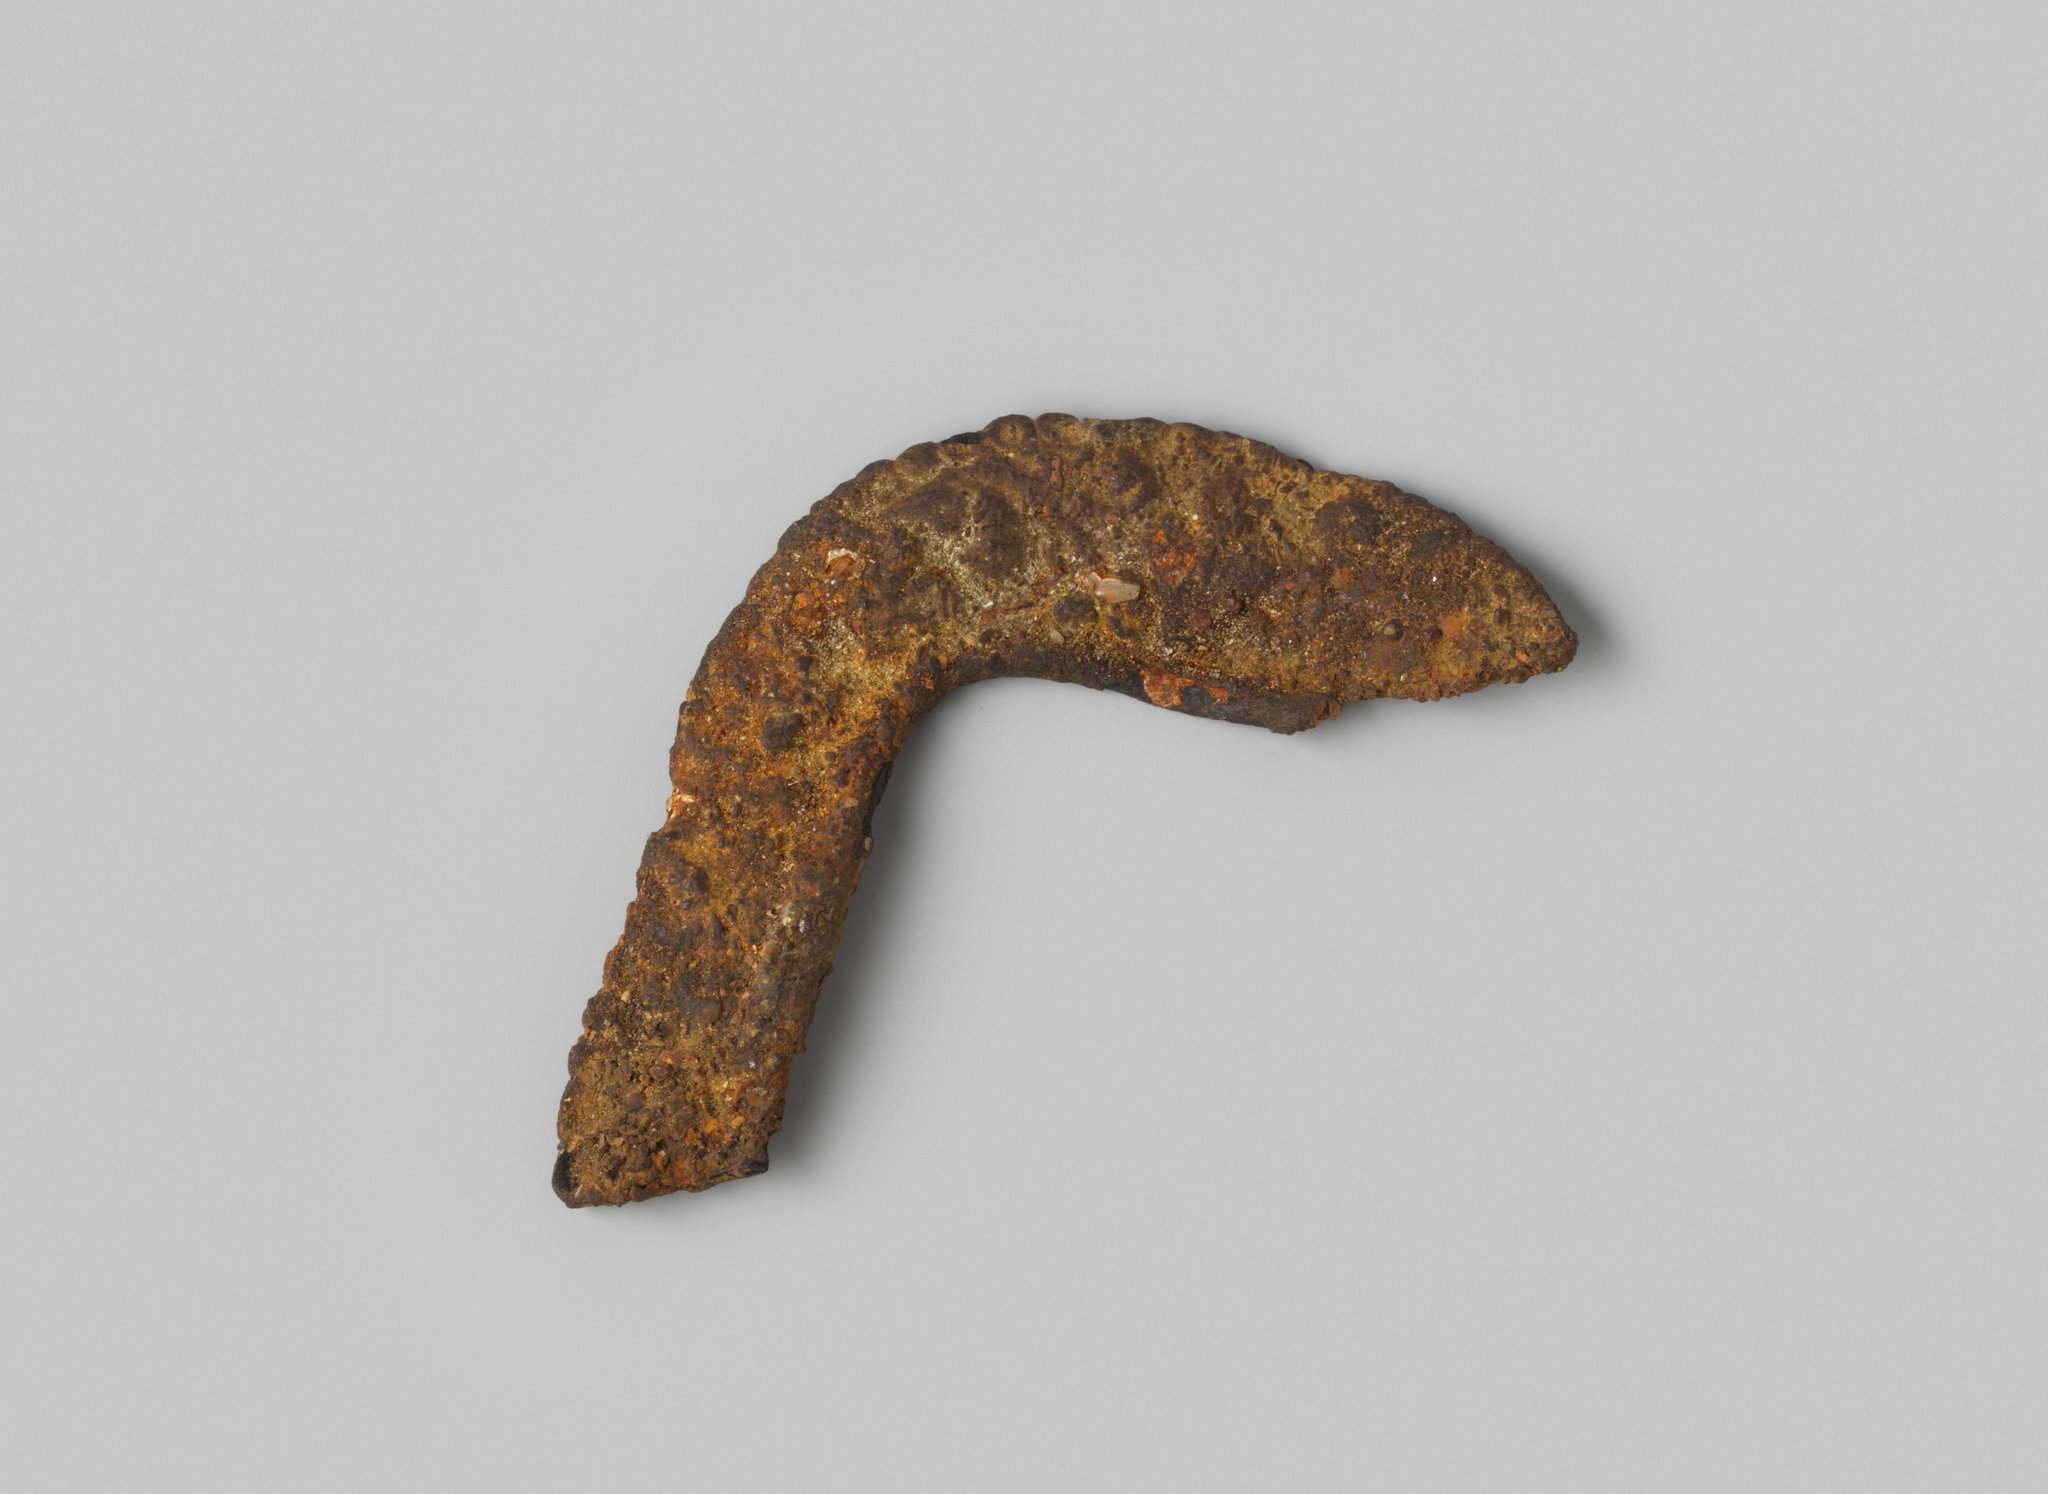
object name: shoe buckle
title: Fragment schoengesp uit het wrak van de Oost-Indiëvaarder Hollandia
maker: Anonymous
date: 1700-1743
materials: silver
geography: netherlands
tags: verenigde oostindische compagnie, hollandia (schip), annet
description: Buckle, chape buckle, shoe buckle; fragment of ring, eroded, relieved scrolling decoration decorated, beaded outer rim, mark legible [I Cor IG].